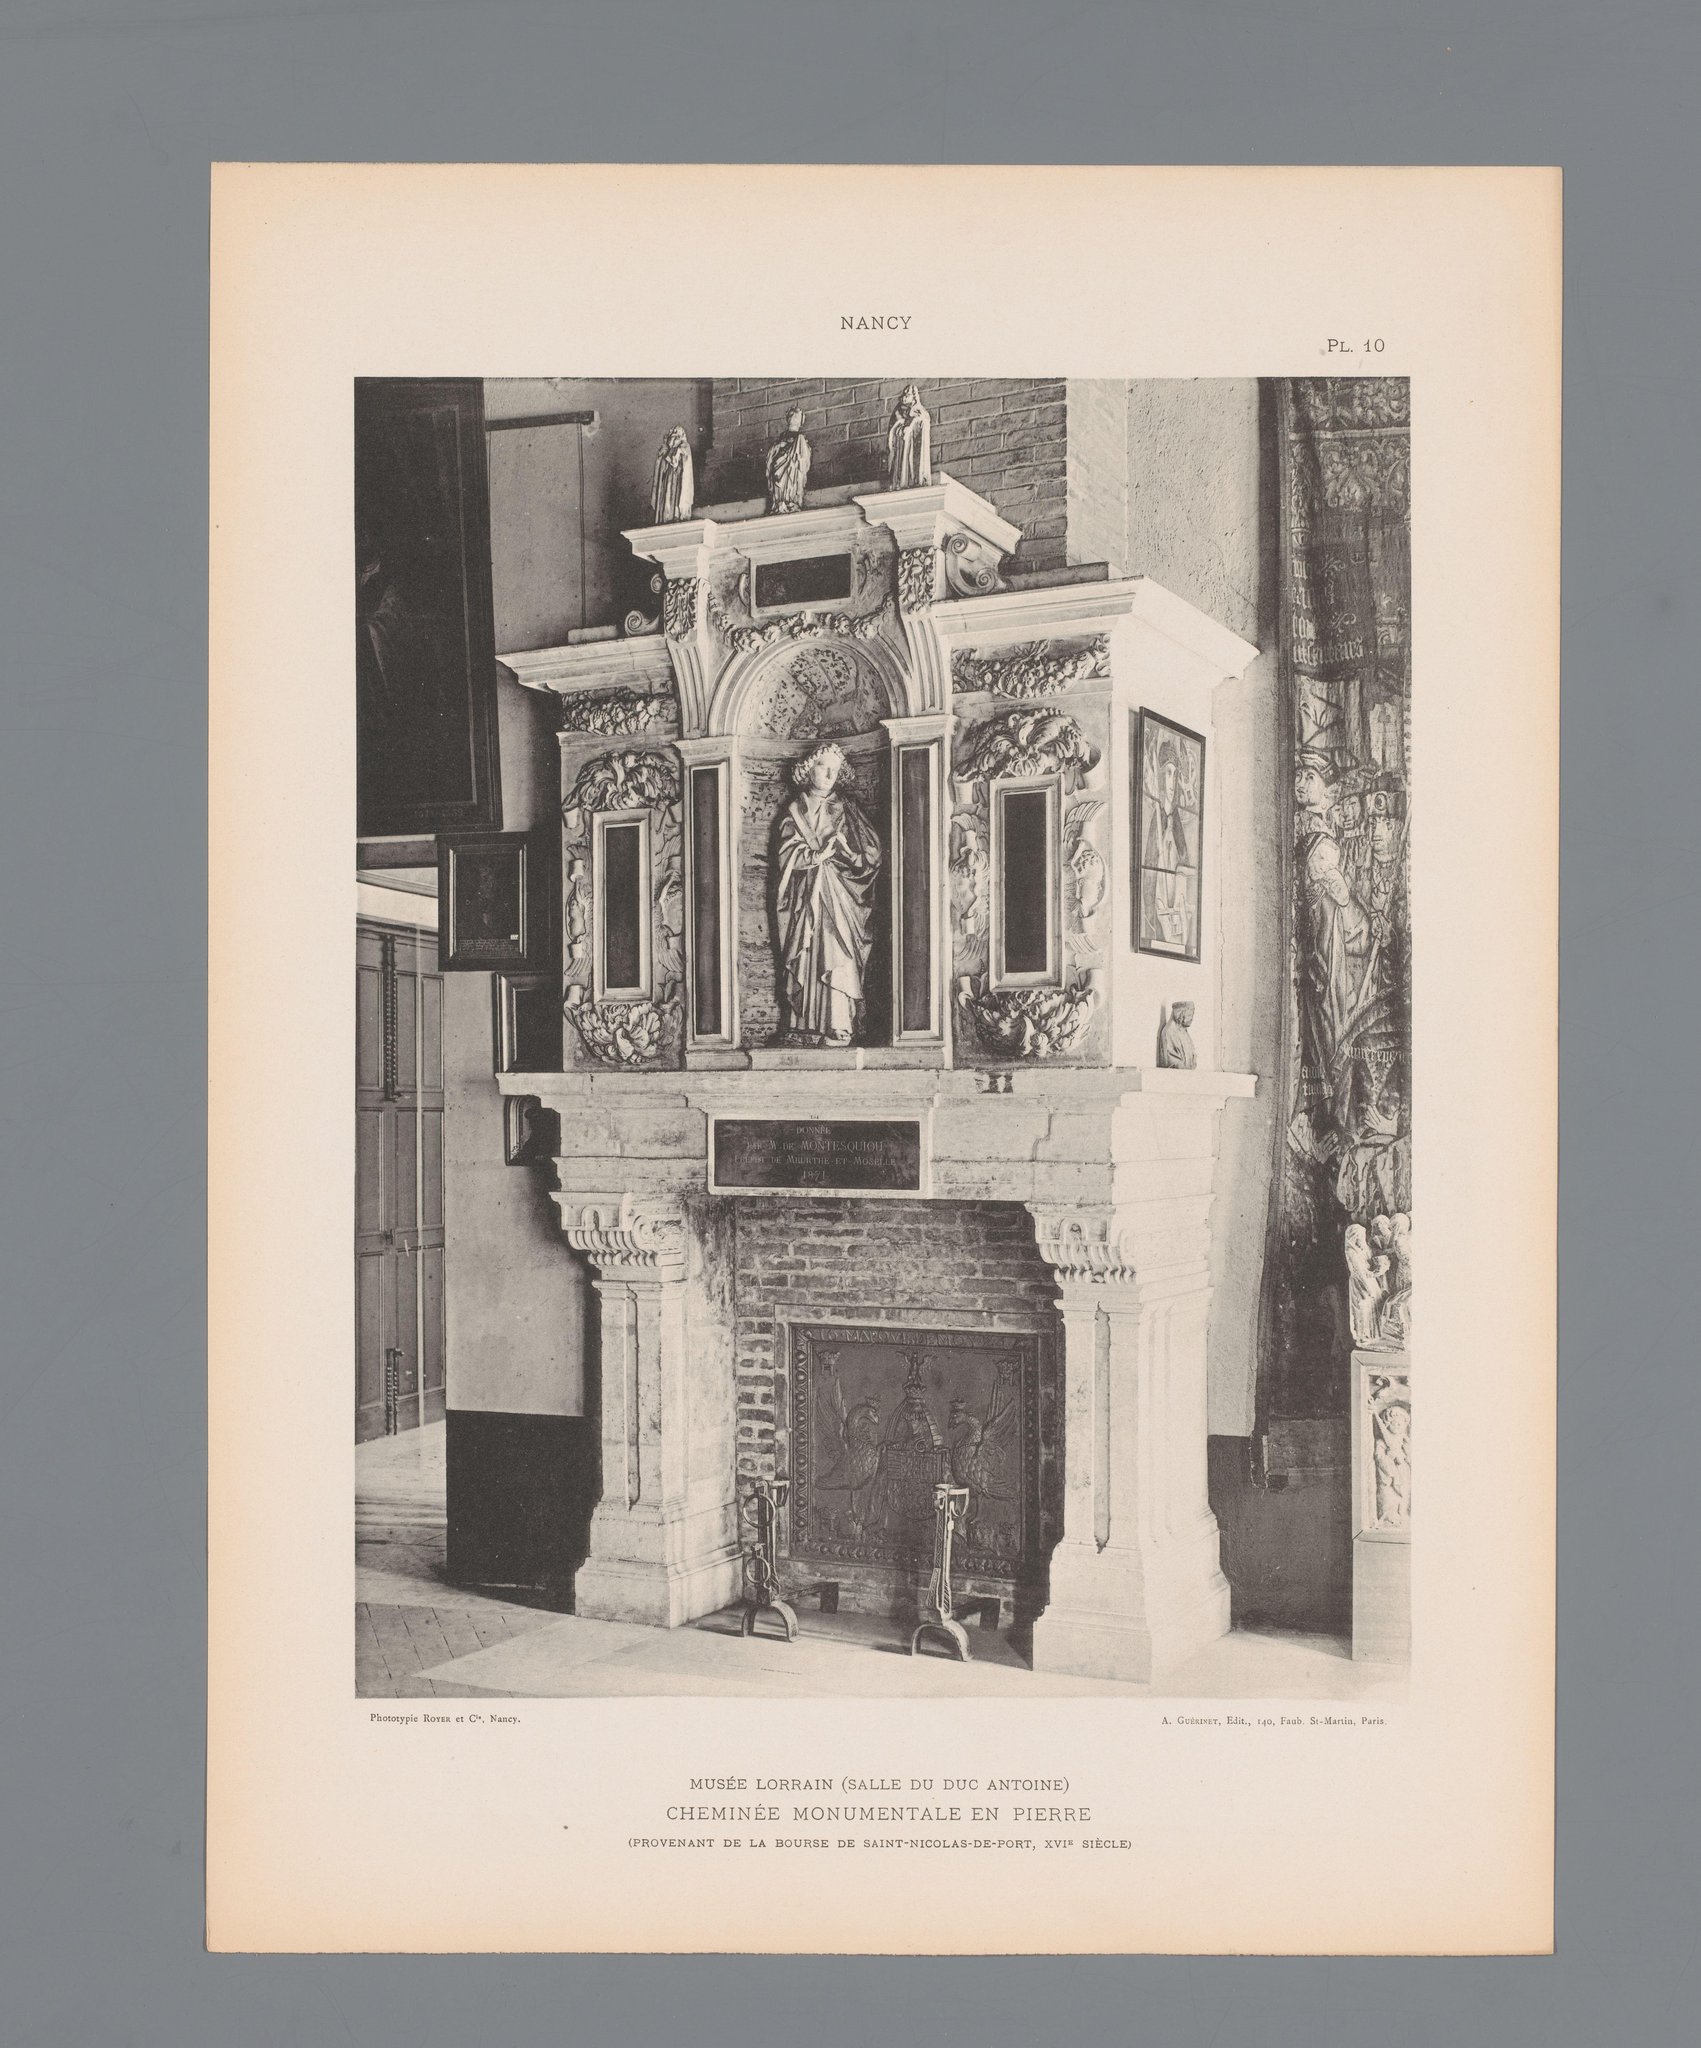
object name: photomechanical print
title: Schoorsteen in Musée Lorrain te Nancy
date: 1891-1896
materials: paper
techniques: photograph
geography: paris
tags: art collection, art gallery, chimney-piece, mantelpiece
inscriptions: inscription: ‘Cheminée monumentale en pierre (...)’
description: Deze prent maakt deel uit van een omslag met 103 prenten op 101 bladen en een titelblad.